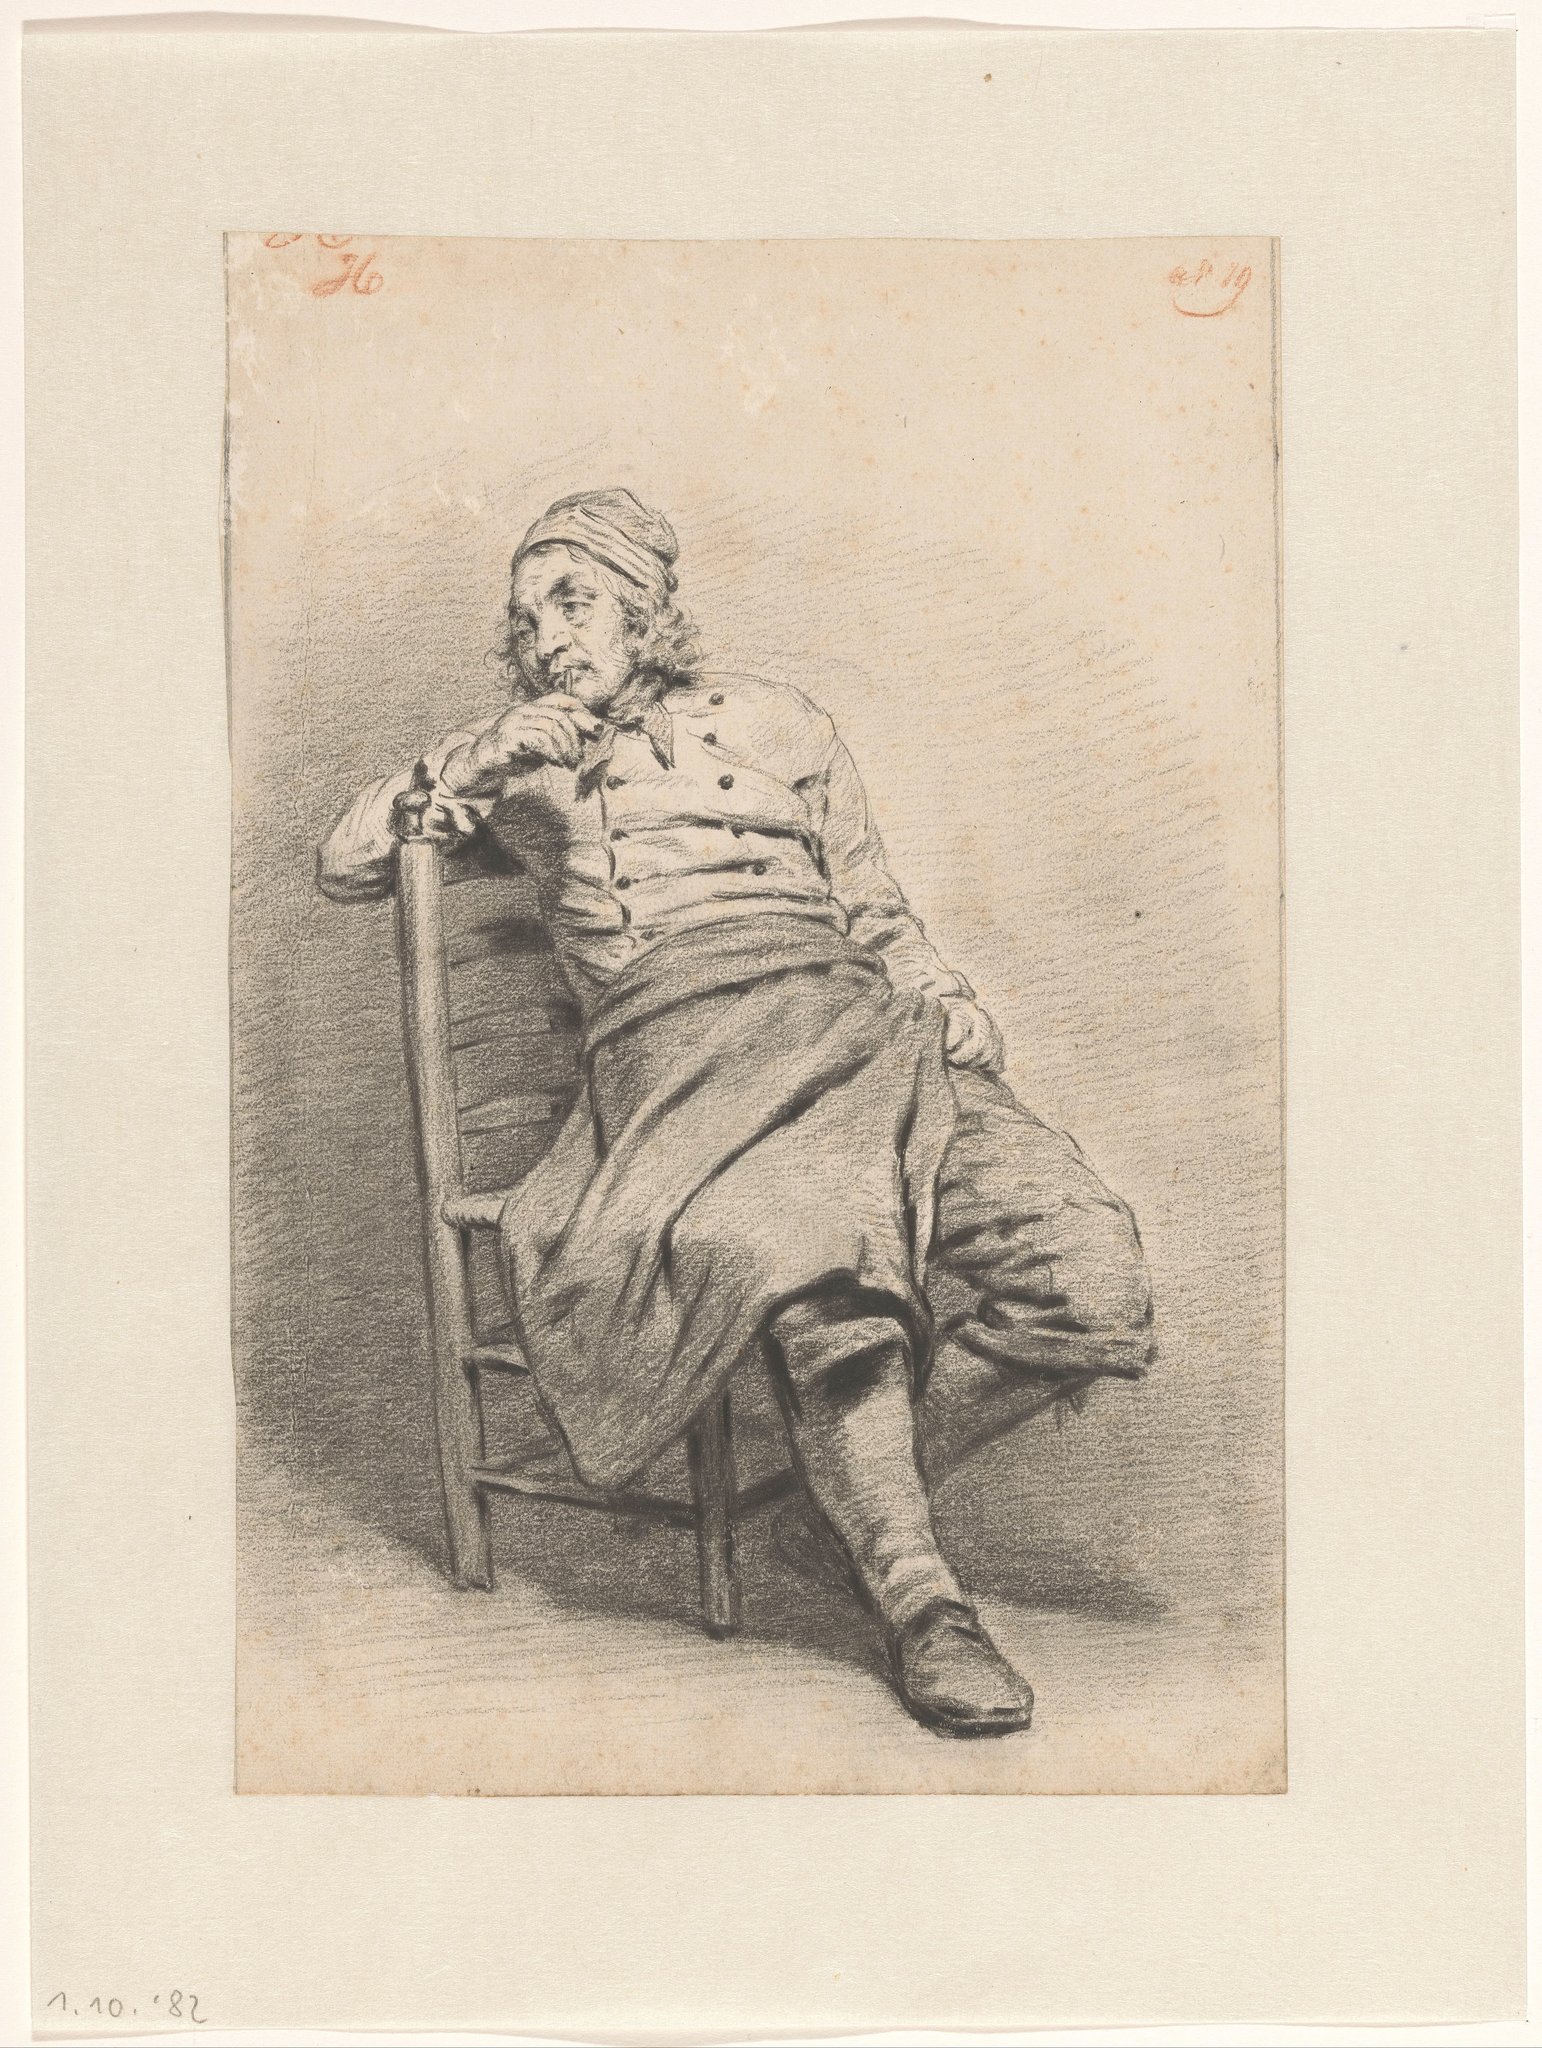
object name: drawing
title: Man zittend op een stoel, met een pijp in de mond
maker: pieter christoffel wonder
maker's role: draughtsman, painter, print maker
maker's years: 1780-1852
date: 1790-1852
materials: chalk, paper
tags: sitting figure, pipe ~ tobacco (+ taking (particular) foodstuffs: eating, drinking, smoking, chewing, etc.)